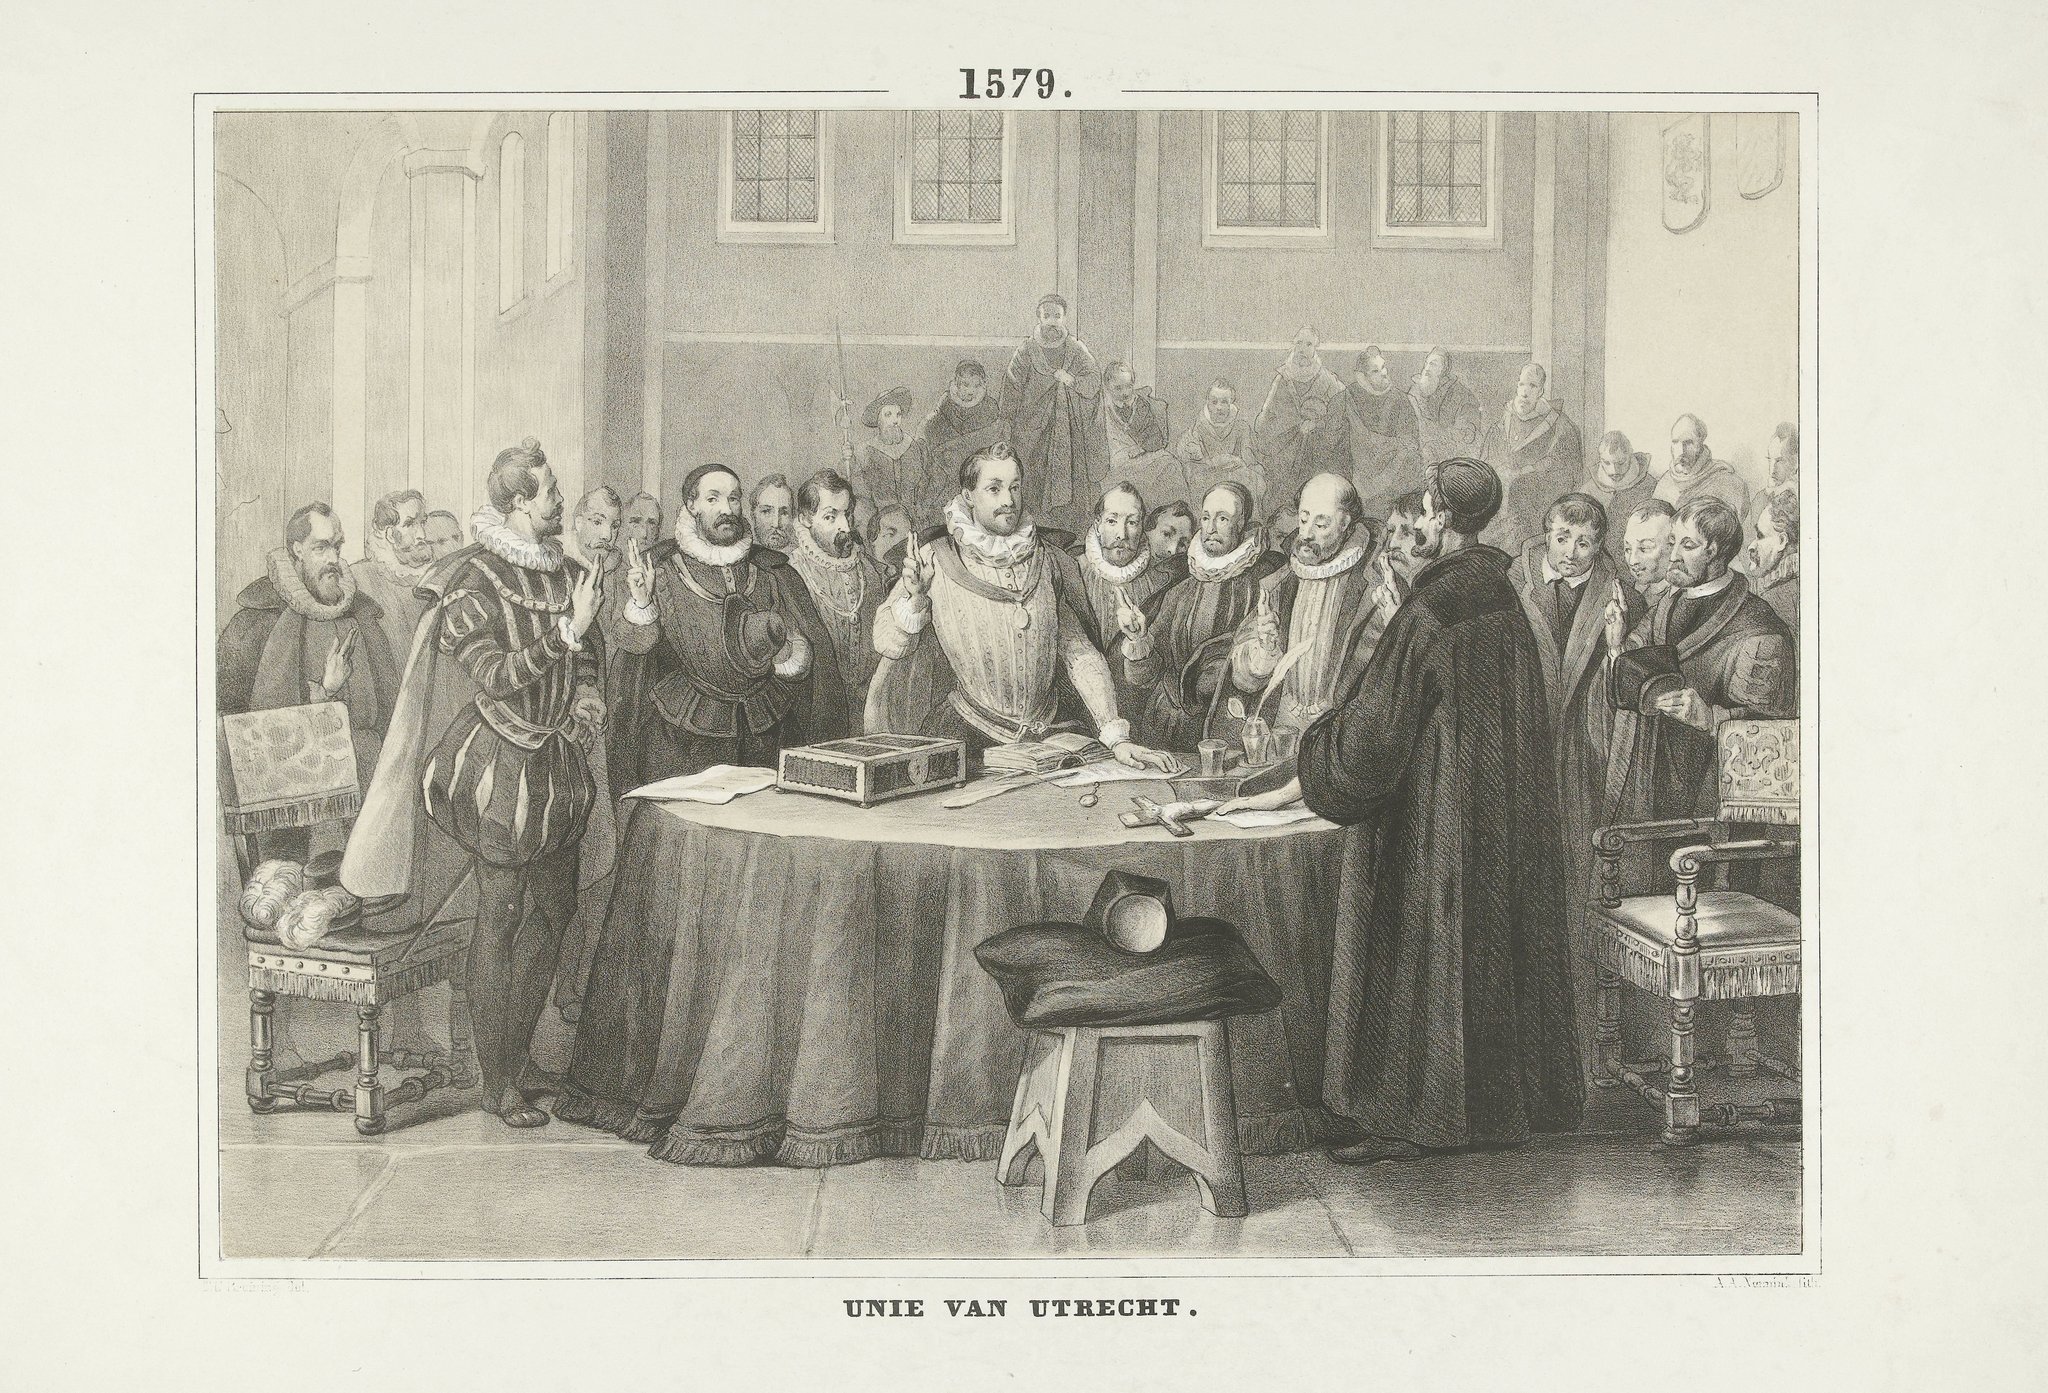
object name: history print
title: 1579 / Unie van Utrecht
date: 1782-1799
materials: paper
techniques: tone lithography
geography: netherlands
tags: signing of peace treaty, concluding the peace, union of utrecht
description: Illustratie voor: J.H. Eichman & H. Altmann, Vaderlandsche historieplaten voor scholen en huisgezinnen, Leiden, 1855. Dit nummer is een door het RPK toegevoegd nummer en staat niet in Frederik Muller, het werk waar de prent voor is gemaakt of uit afkomstig is, staat wel vermeld in Frederik Muller.